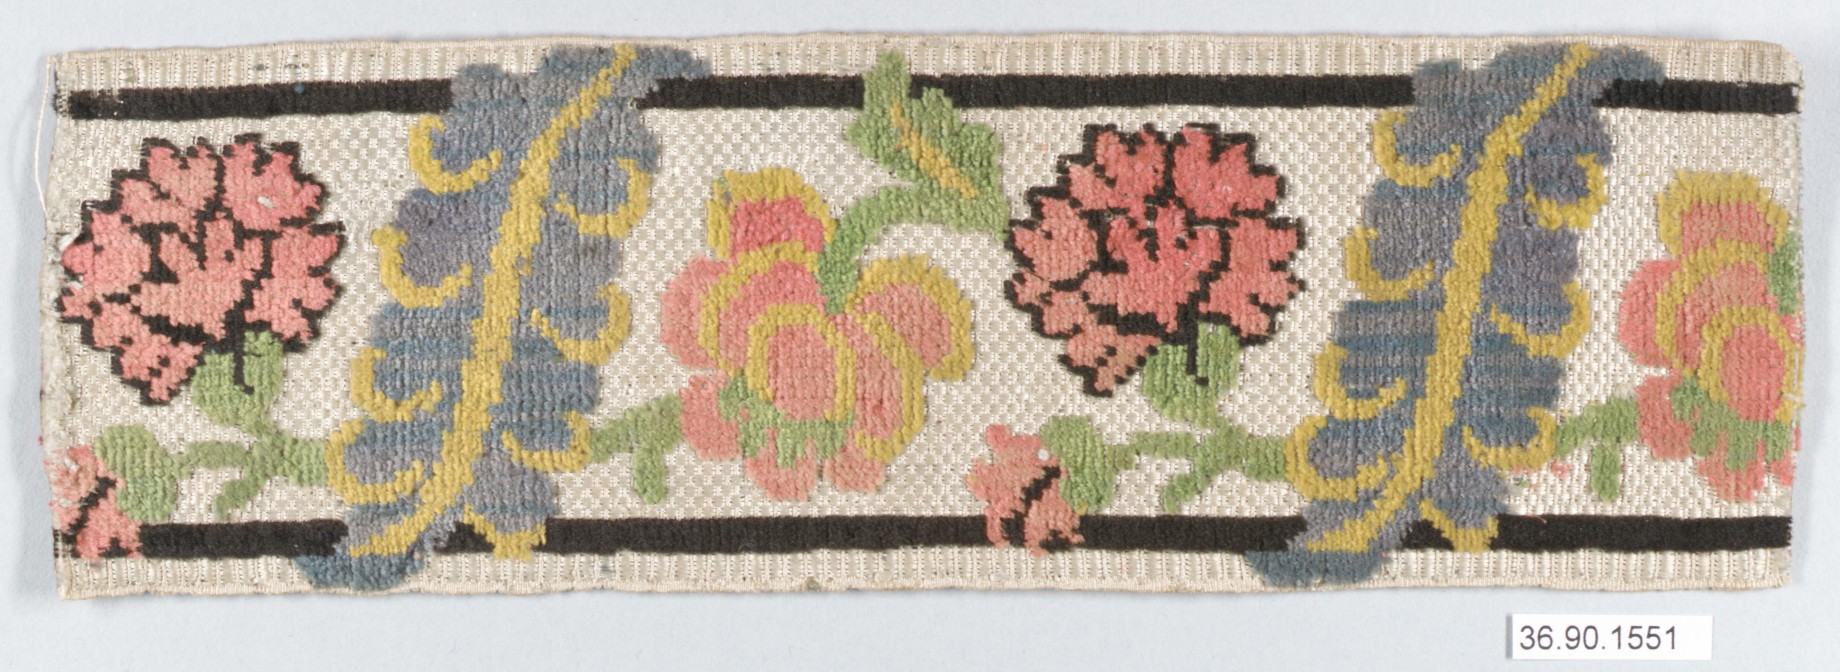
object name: galloon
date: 1701-1900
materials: silk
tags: flowers